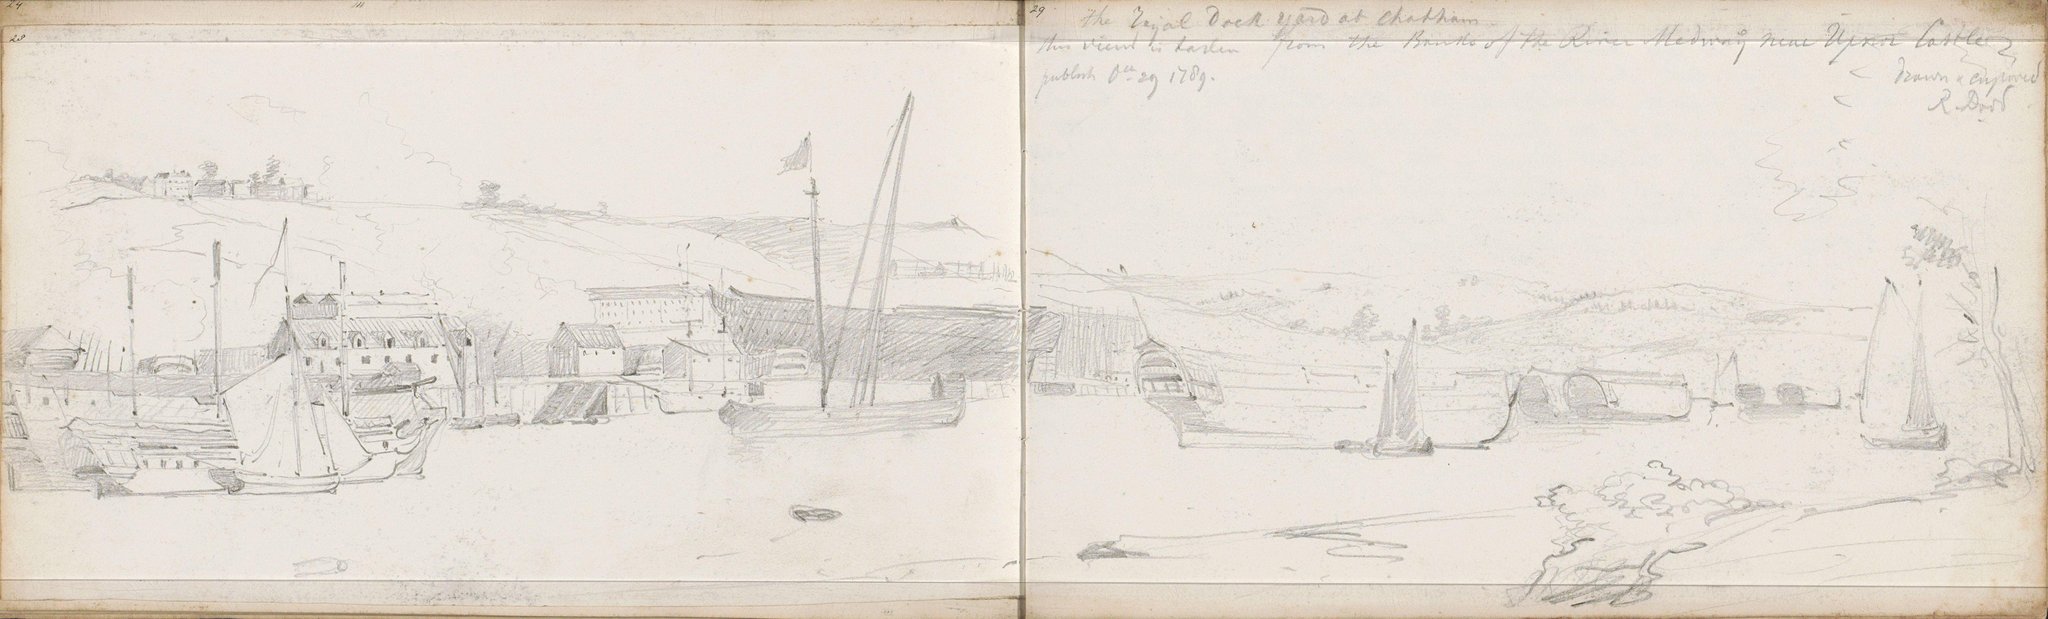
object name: sketchbook leaf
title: Royal Dockyard te Chatham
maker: petrus johannes schotel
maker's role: draughtsman, painter, print maker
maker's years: 1808-1865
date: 1841-1865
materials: paper, pencil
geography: chatham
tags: dry-dock, floating-dock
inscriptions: annotation: ‘The Royal Dock yard at Chatham/ this view is taken from the Bank of the River Medway near Rynor Castle/ publ Oct 29 1789/ drawn & engraved/ R.Dodd’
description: Pagina 28 en 29 uit een schetsboek met 80 pagina's.